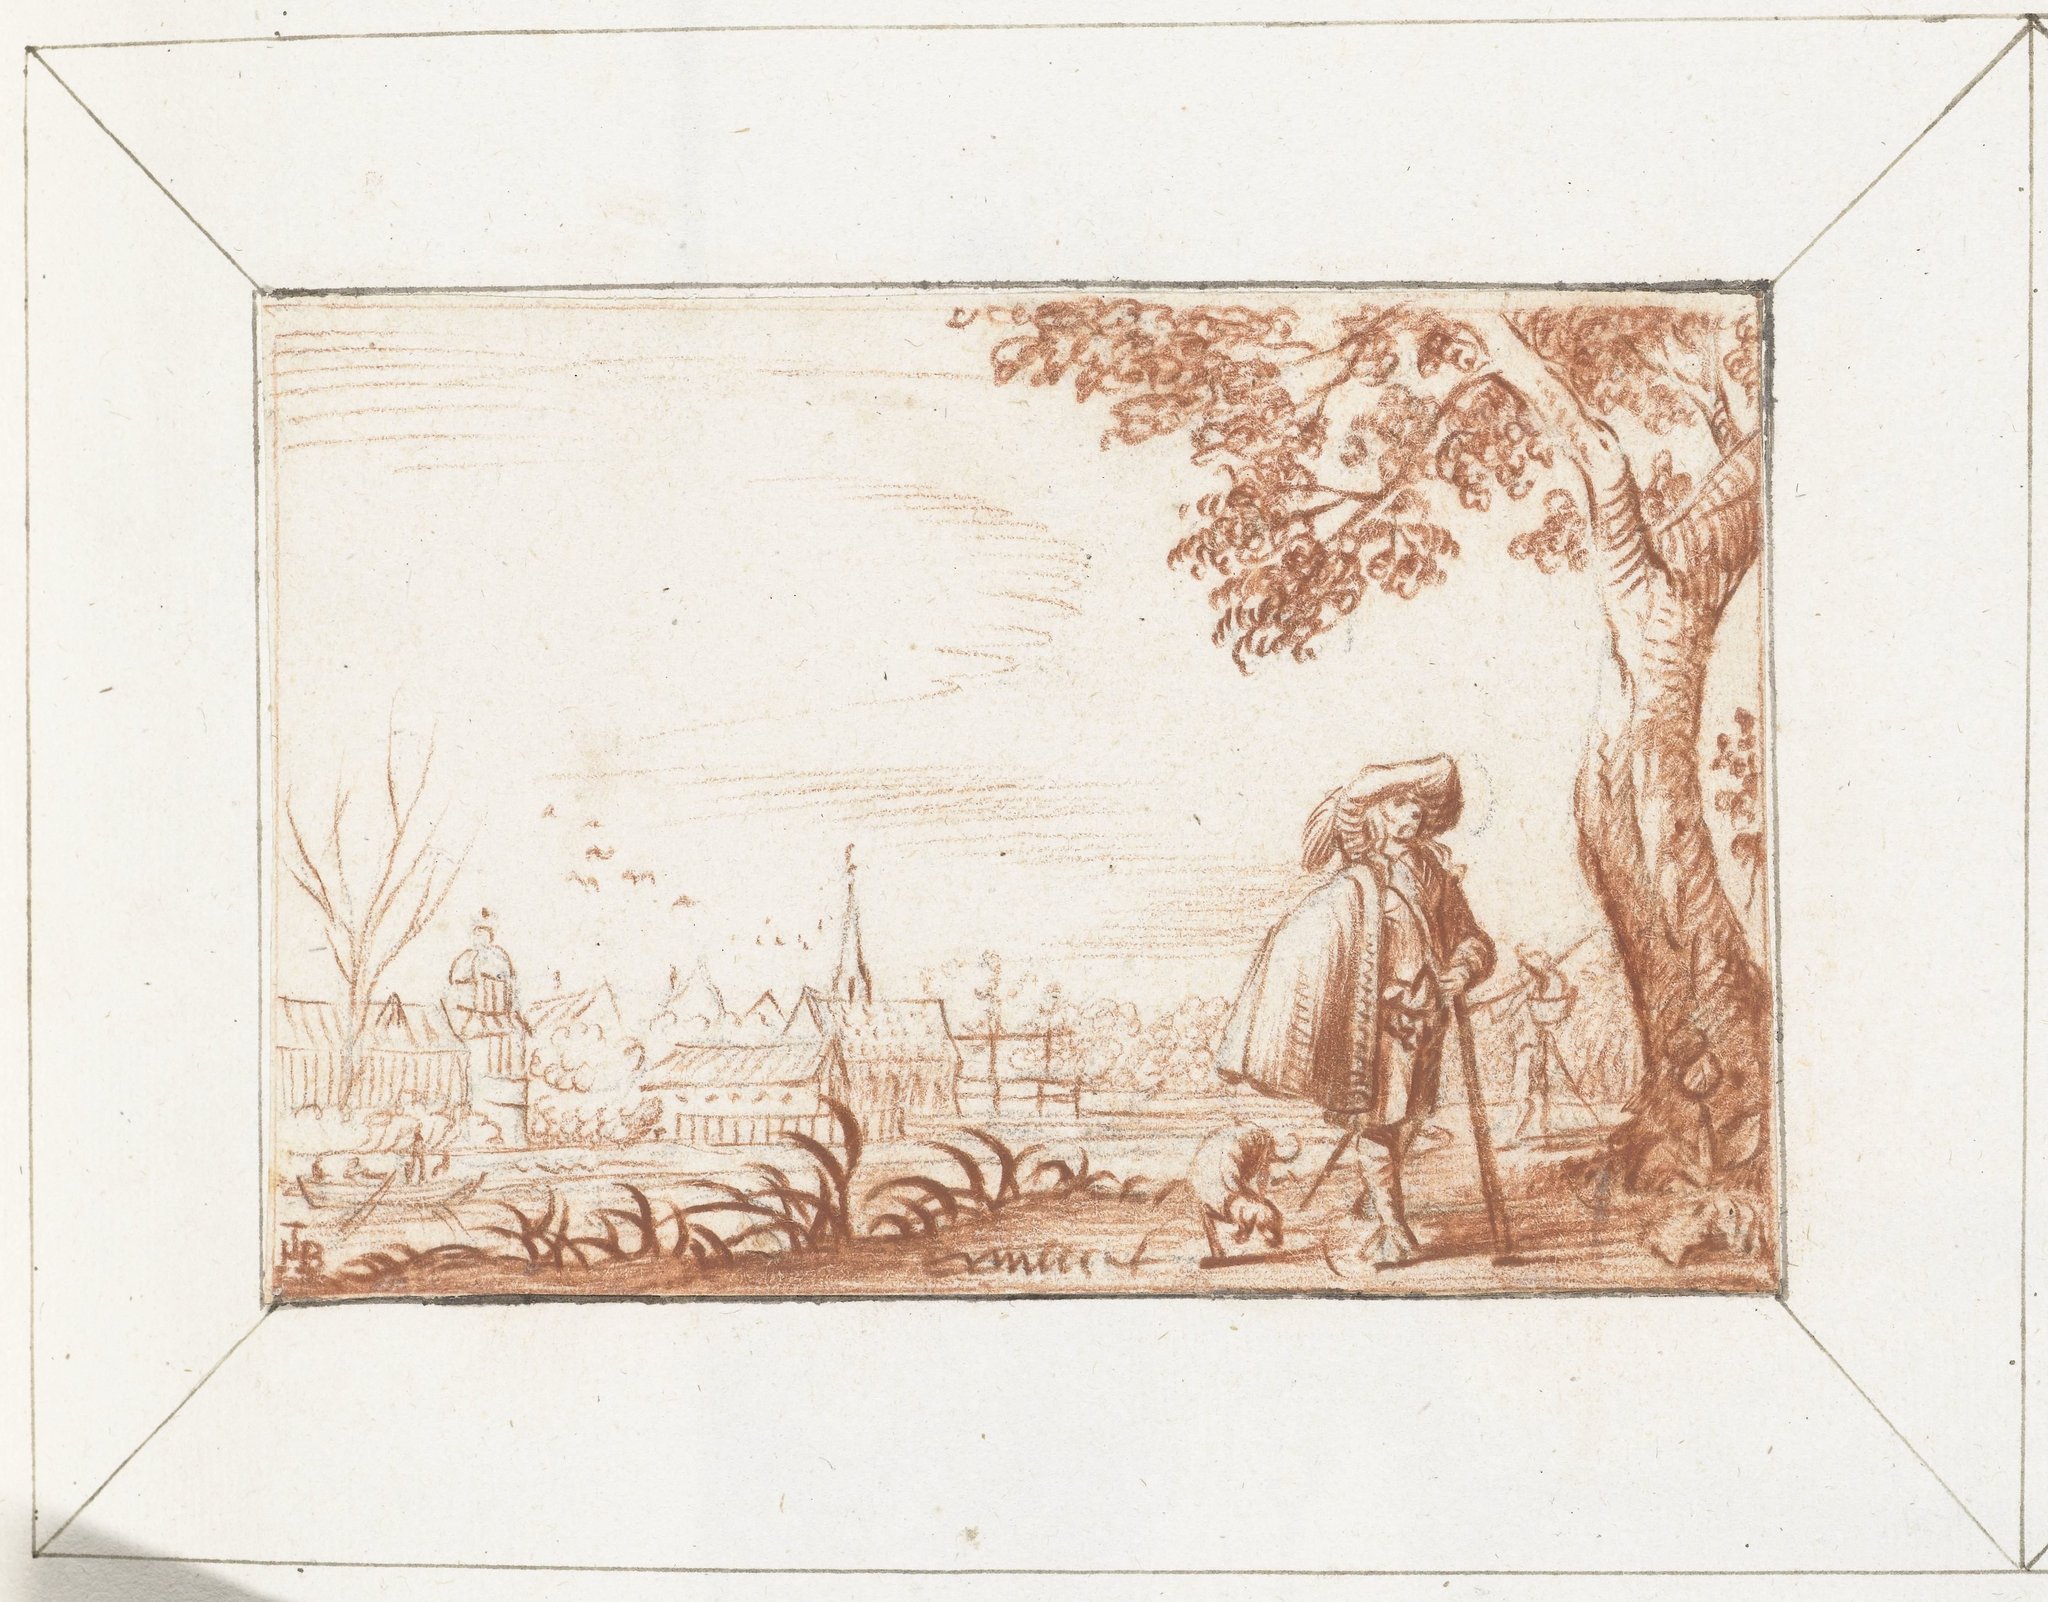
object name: drawing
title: Heer staand op een rivieroever tegenover een stad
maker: harmen ter borch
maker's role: draughtsman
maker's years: 1638-1677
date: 1648-1677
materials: chalk, paper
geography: zwolle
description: Heer staand op een rivieroever tegenover een stad, waarschijnlijk Hattem.